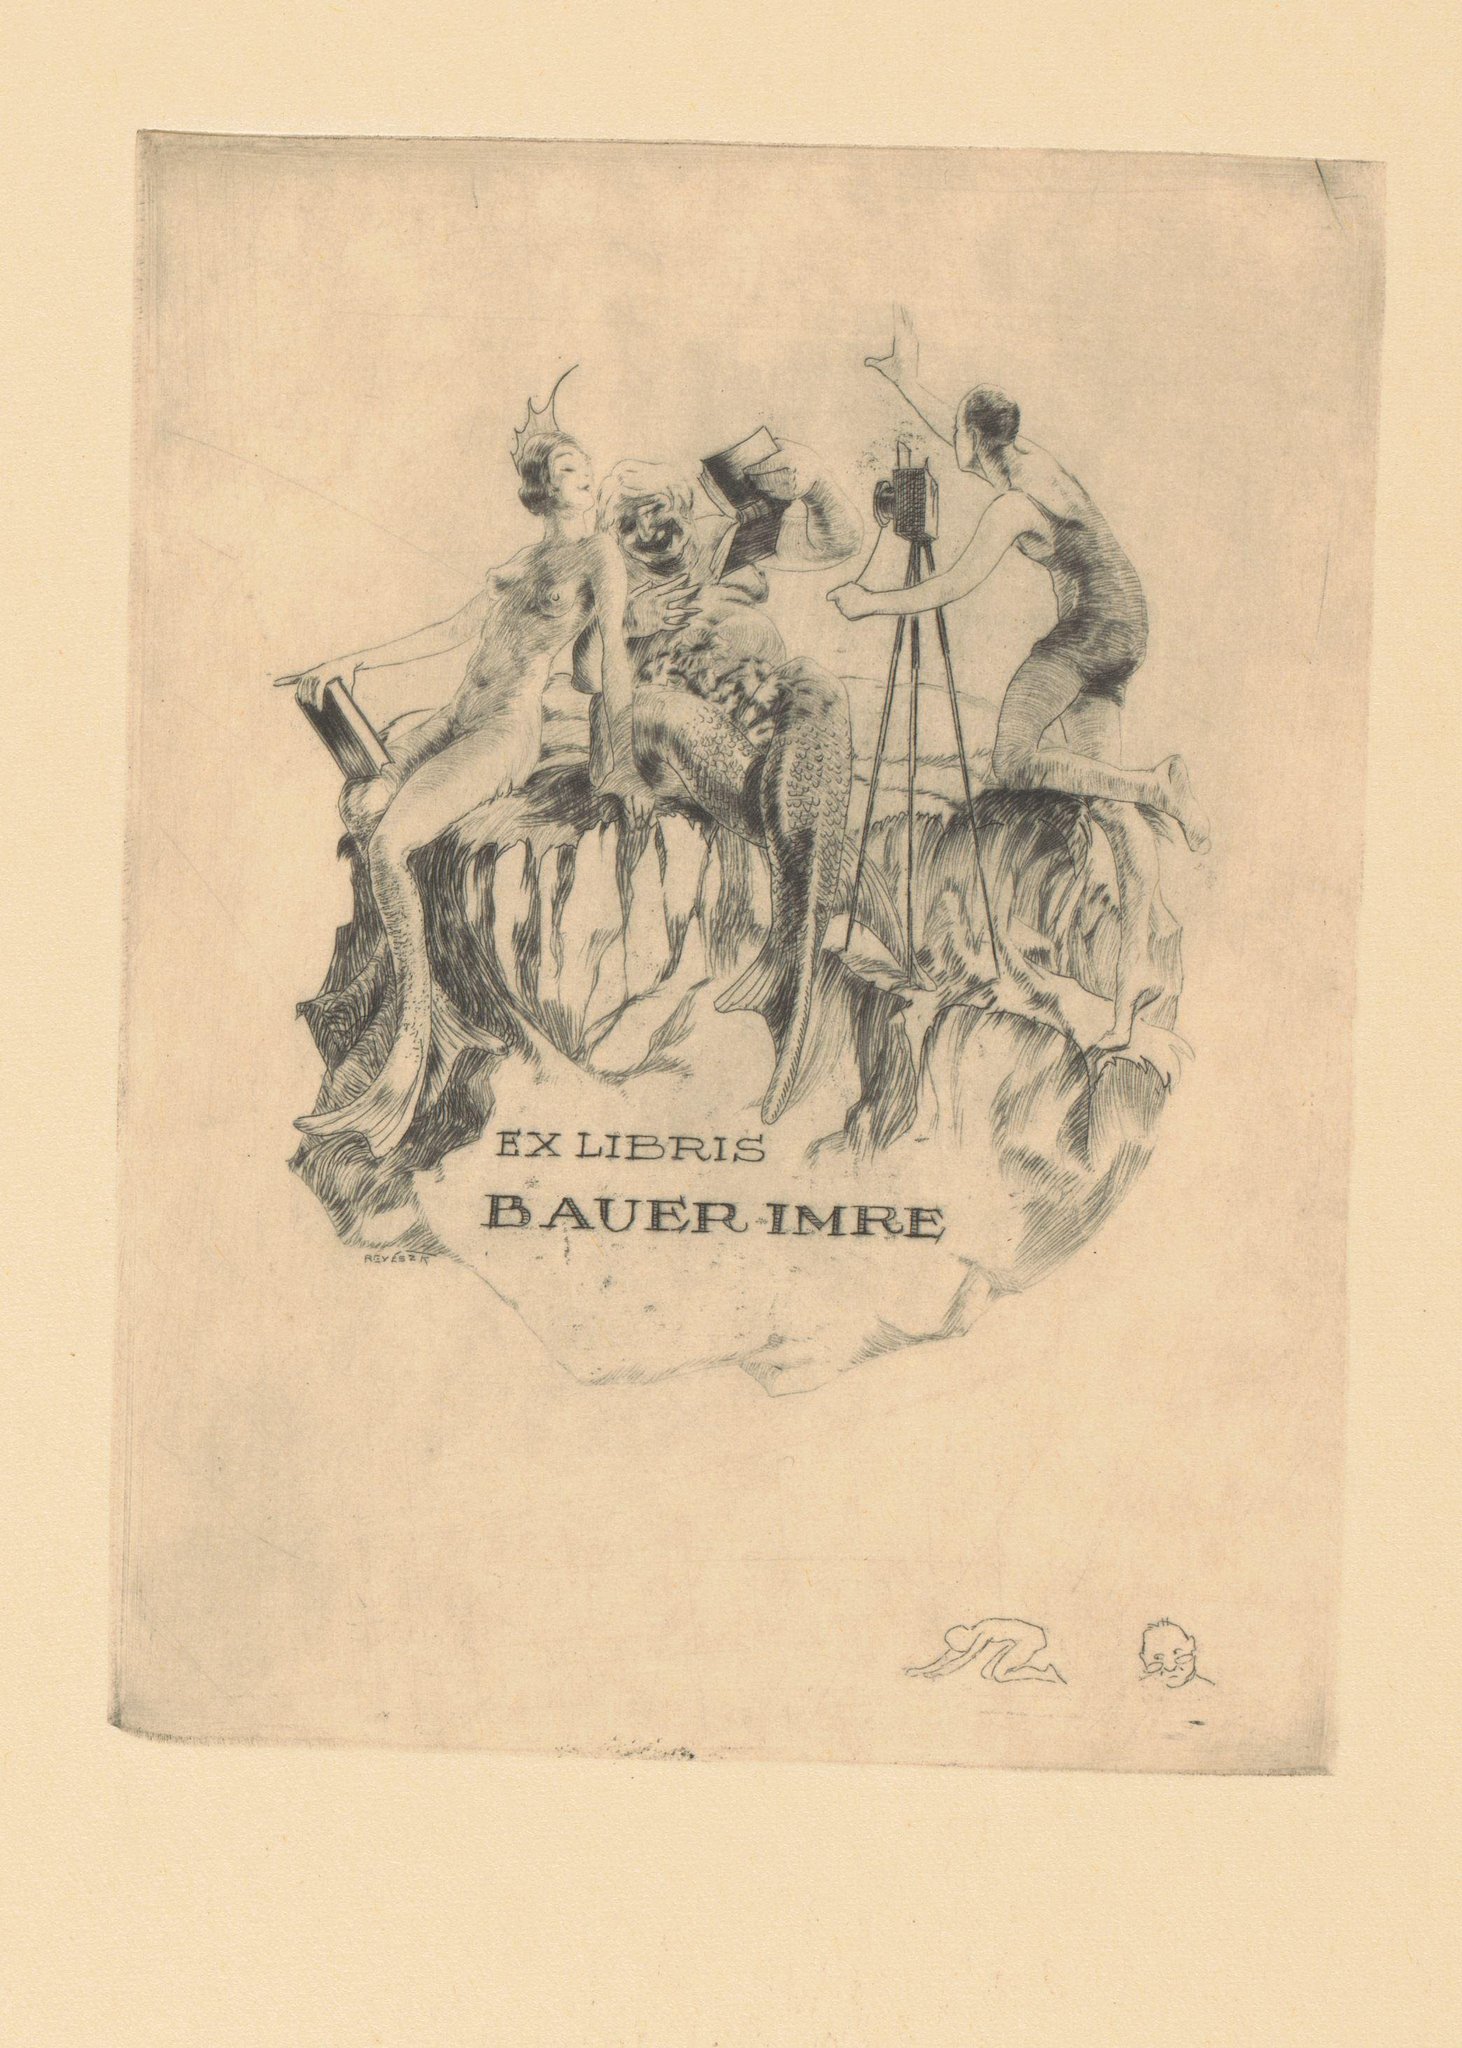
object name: bookplate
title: Ex libris Bauer Imre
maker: kornél révész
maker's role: print maker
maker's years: 1885-1944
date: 1895-1936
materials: paper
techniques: drypoint, etching, intaglio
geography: hungary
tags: merman - aa - mermaid, siren, taking photographs, woman (showing herself) undressed, quasi-nude, old woman, book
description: Prent is deel van een catalogus met 13 ingebonden objecten en twee tekstbladen. Catalogus is deel van een omslag met 64 objecten op 34 opzetvellen en een tekstblad.